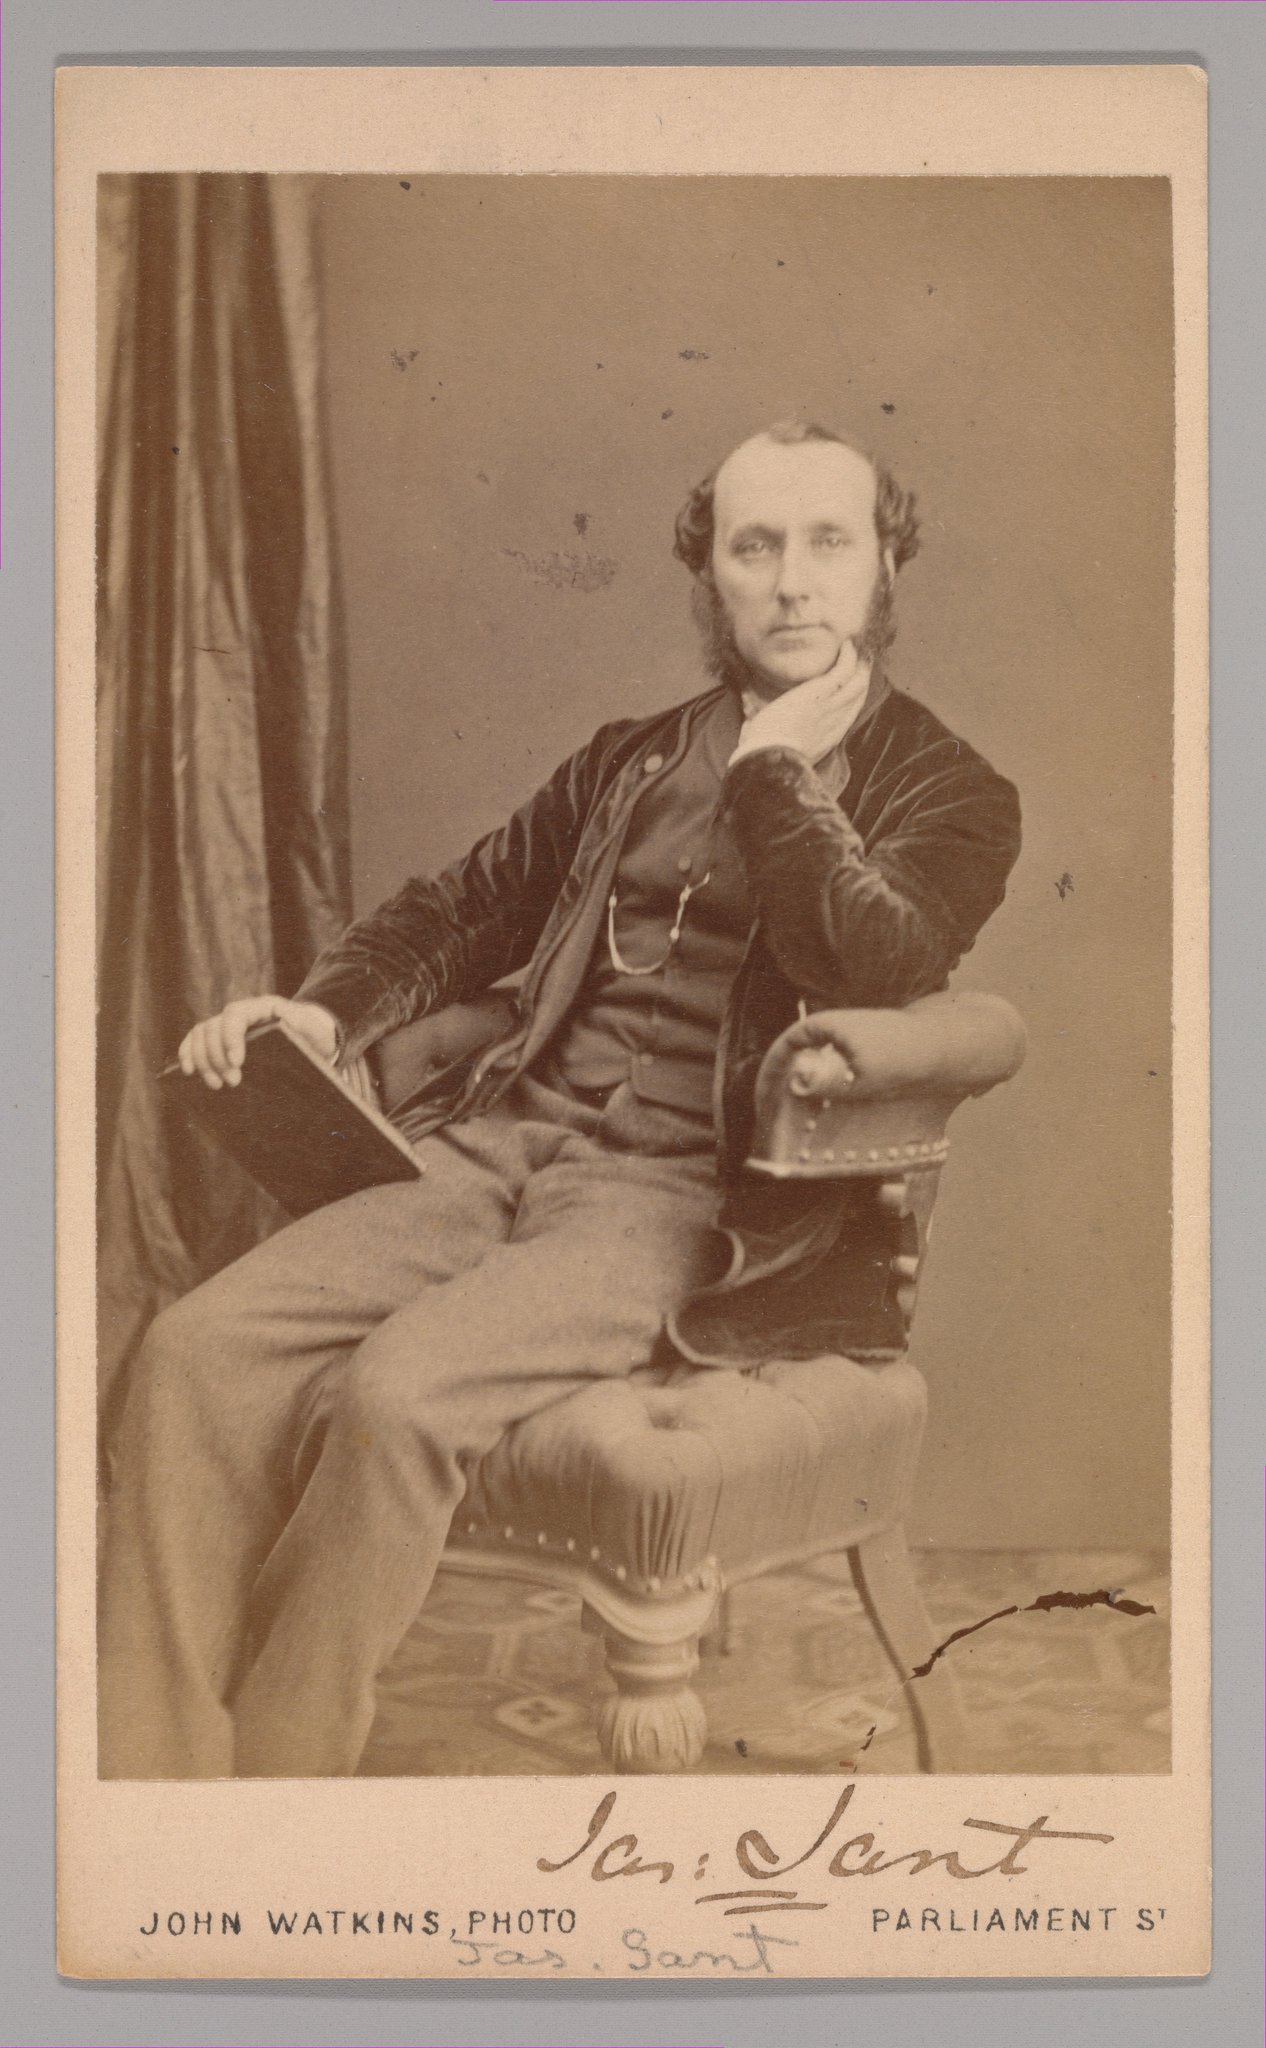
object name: carte de visite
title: [James Sant]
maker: john and charles watkins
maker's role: photography studio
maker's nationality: british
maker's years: 1840-1875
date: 1860-1869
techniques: albumen silver print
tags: men,portraits